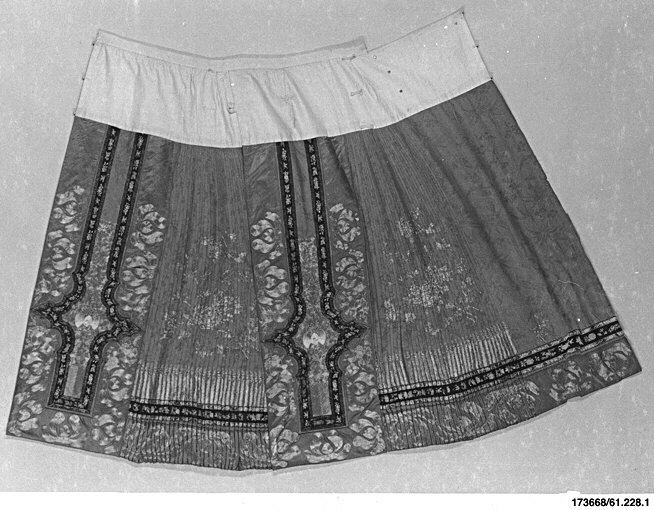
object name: woman's wedding skirt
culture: chinese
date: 1801-1900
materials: metal thread, silk